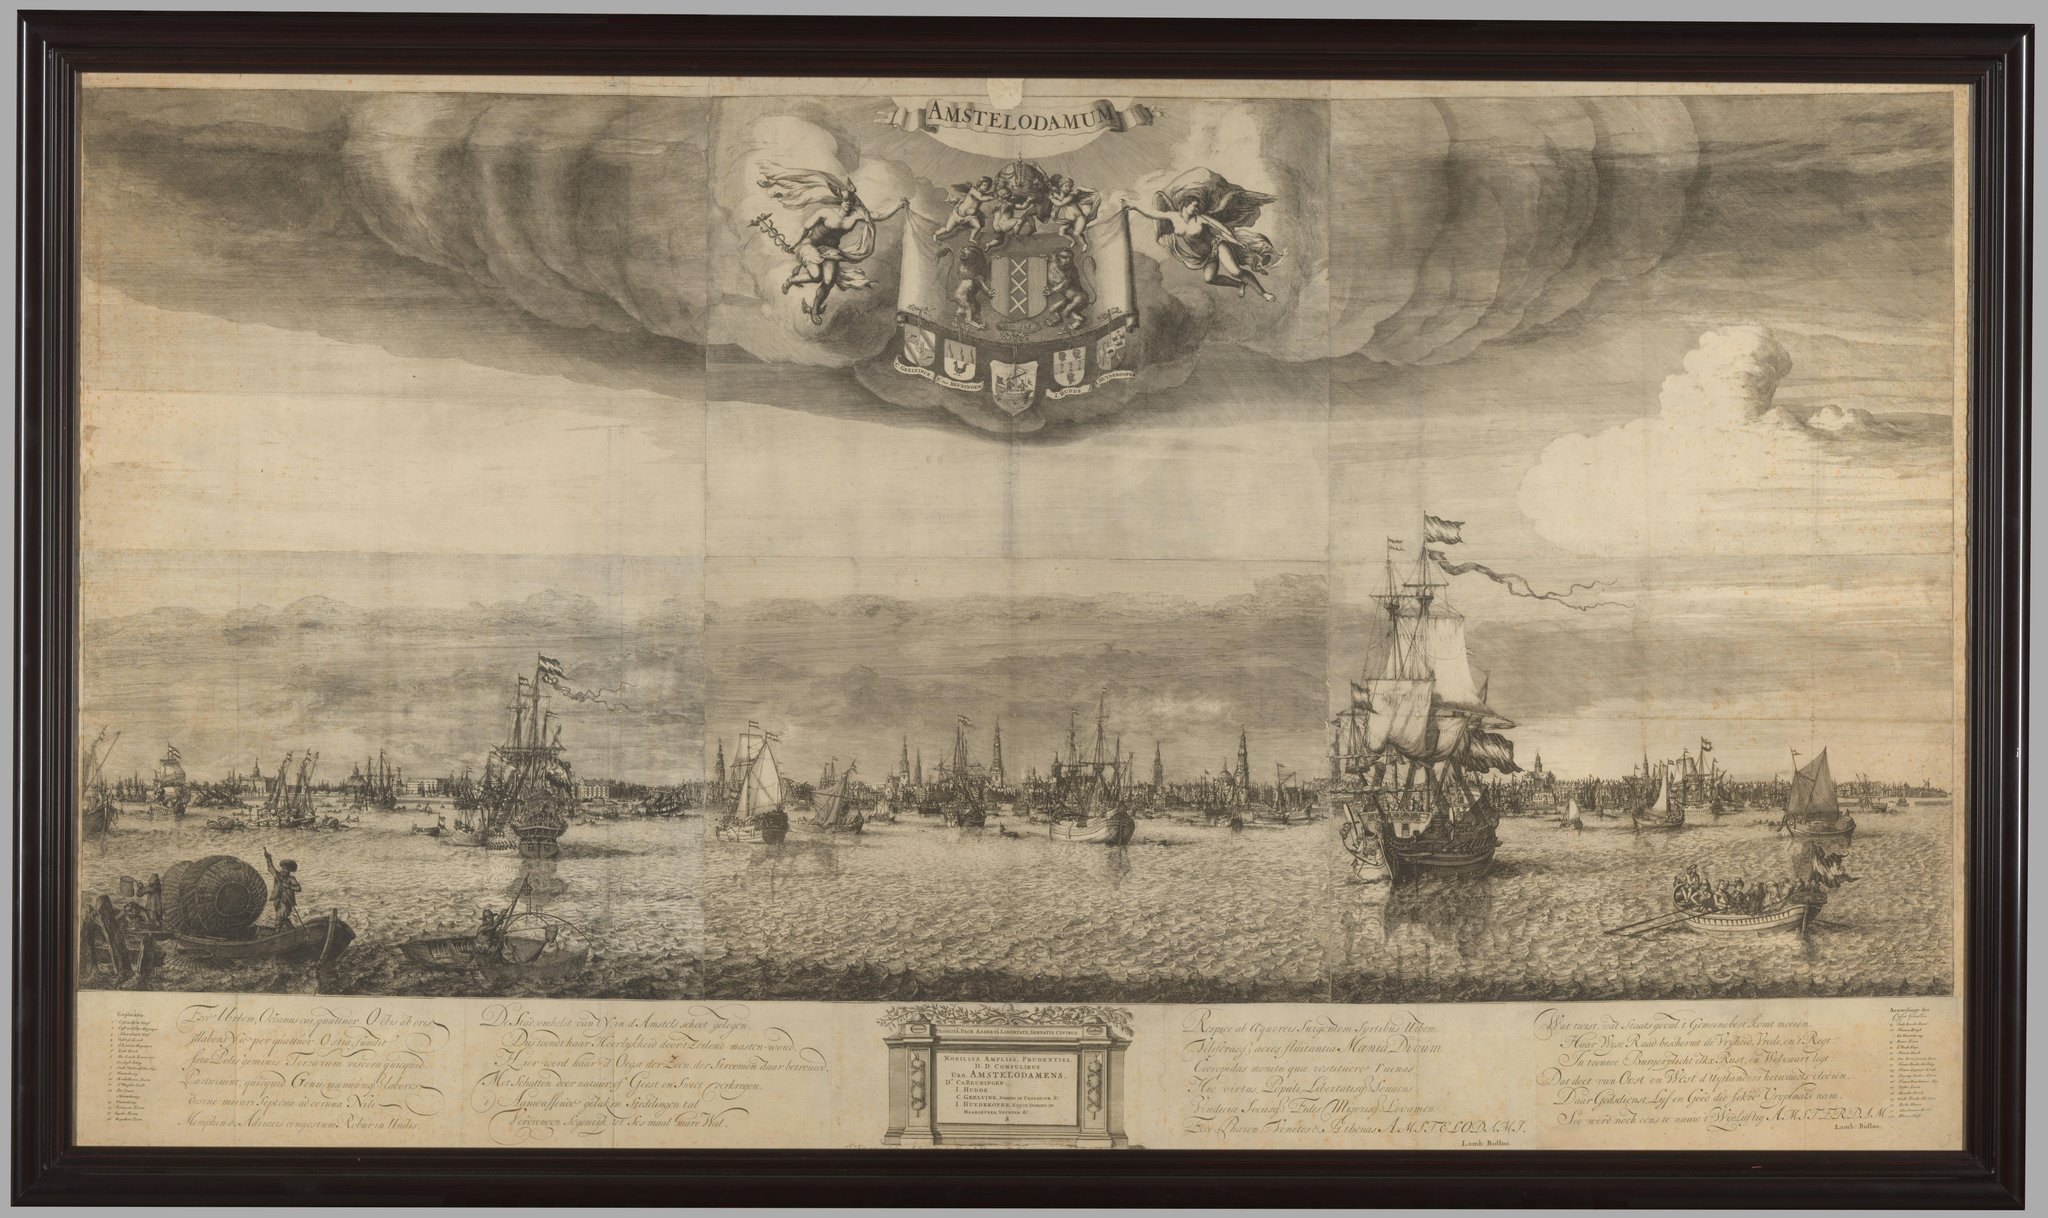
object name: print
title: Amstelodamum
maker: johannes kip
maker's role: print maker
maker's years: 1652-1722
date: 1662-1722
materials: paper, wood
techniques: engraving, etching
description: Ingelijste prent bestaande uit verschillende onderdelen. De lijst is van zwart kunststof.